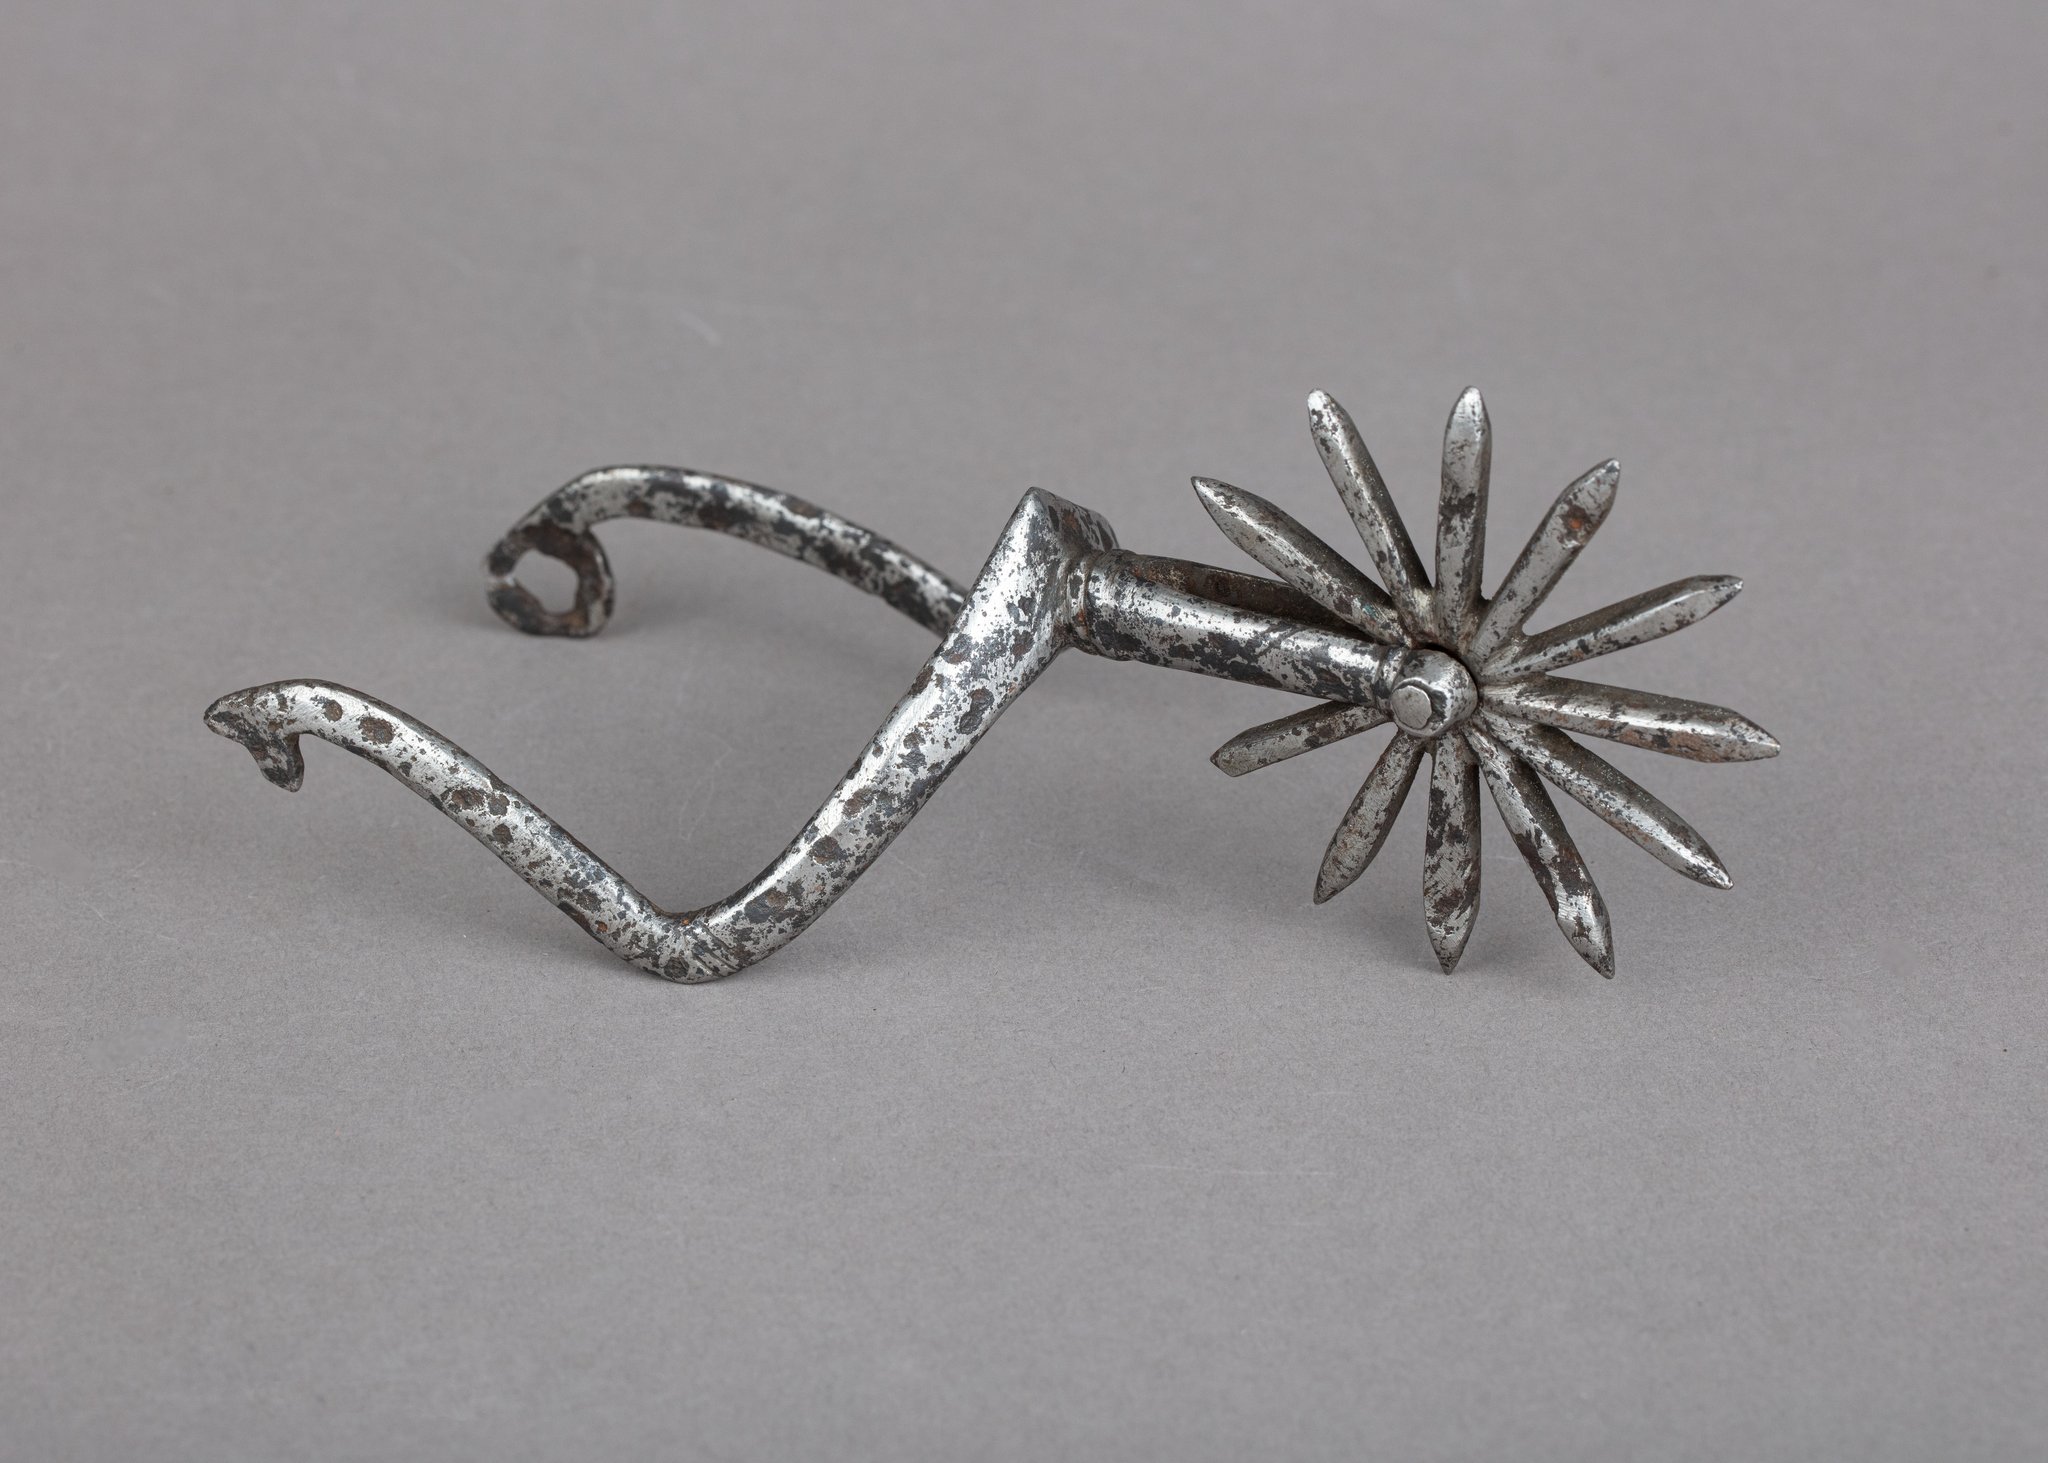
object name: spur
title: Rowel Spur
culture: german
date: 1334-1366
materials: metal alloy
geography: germany